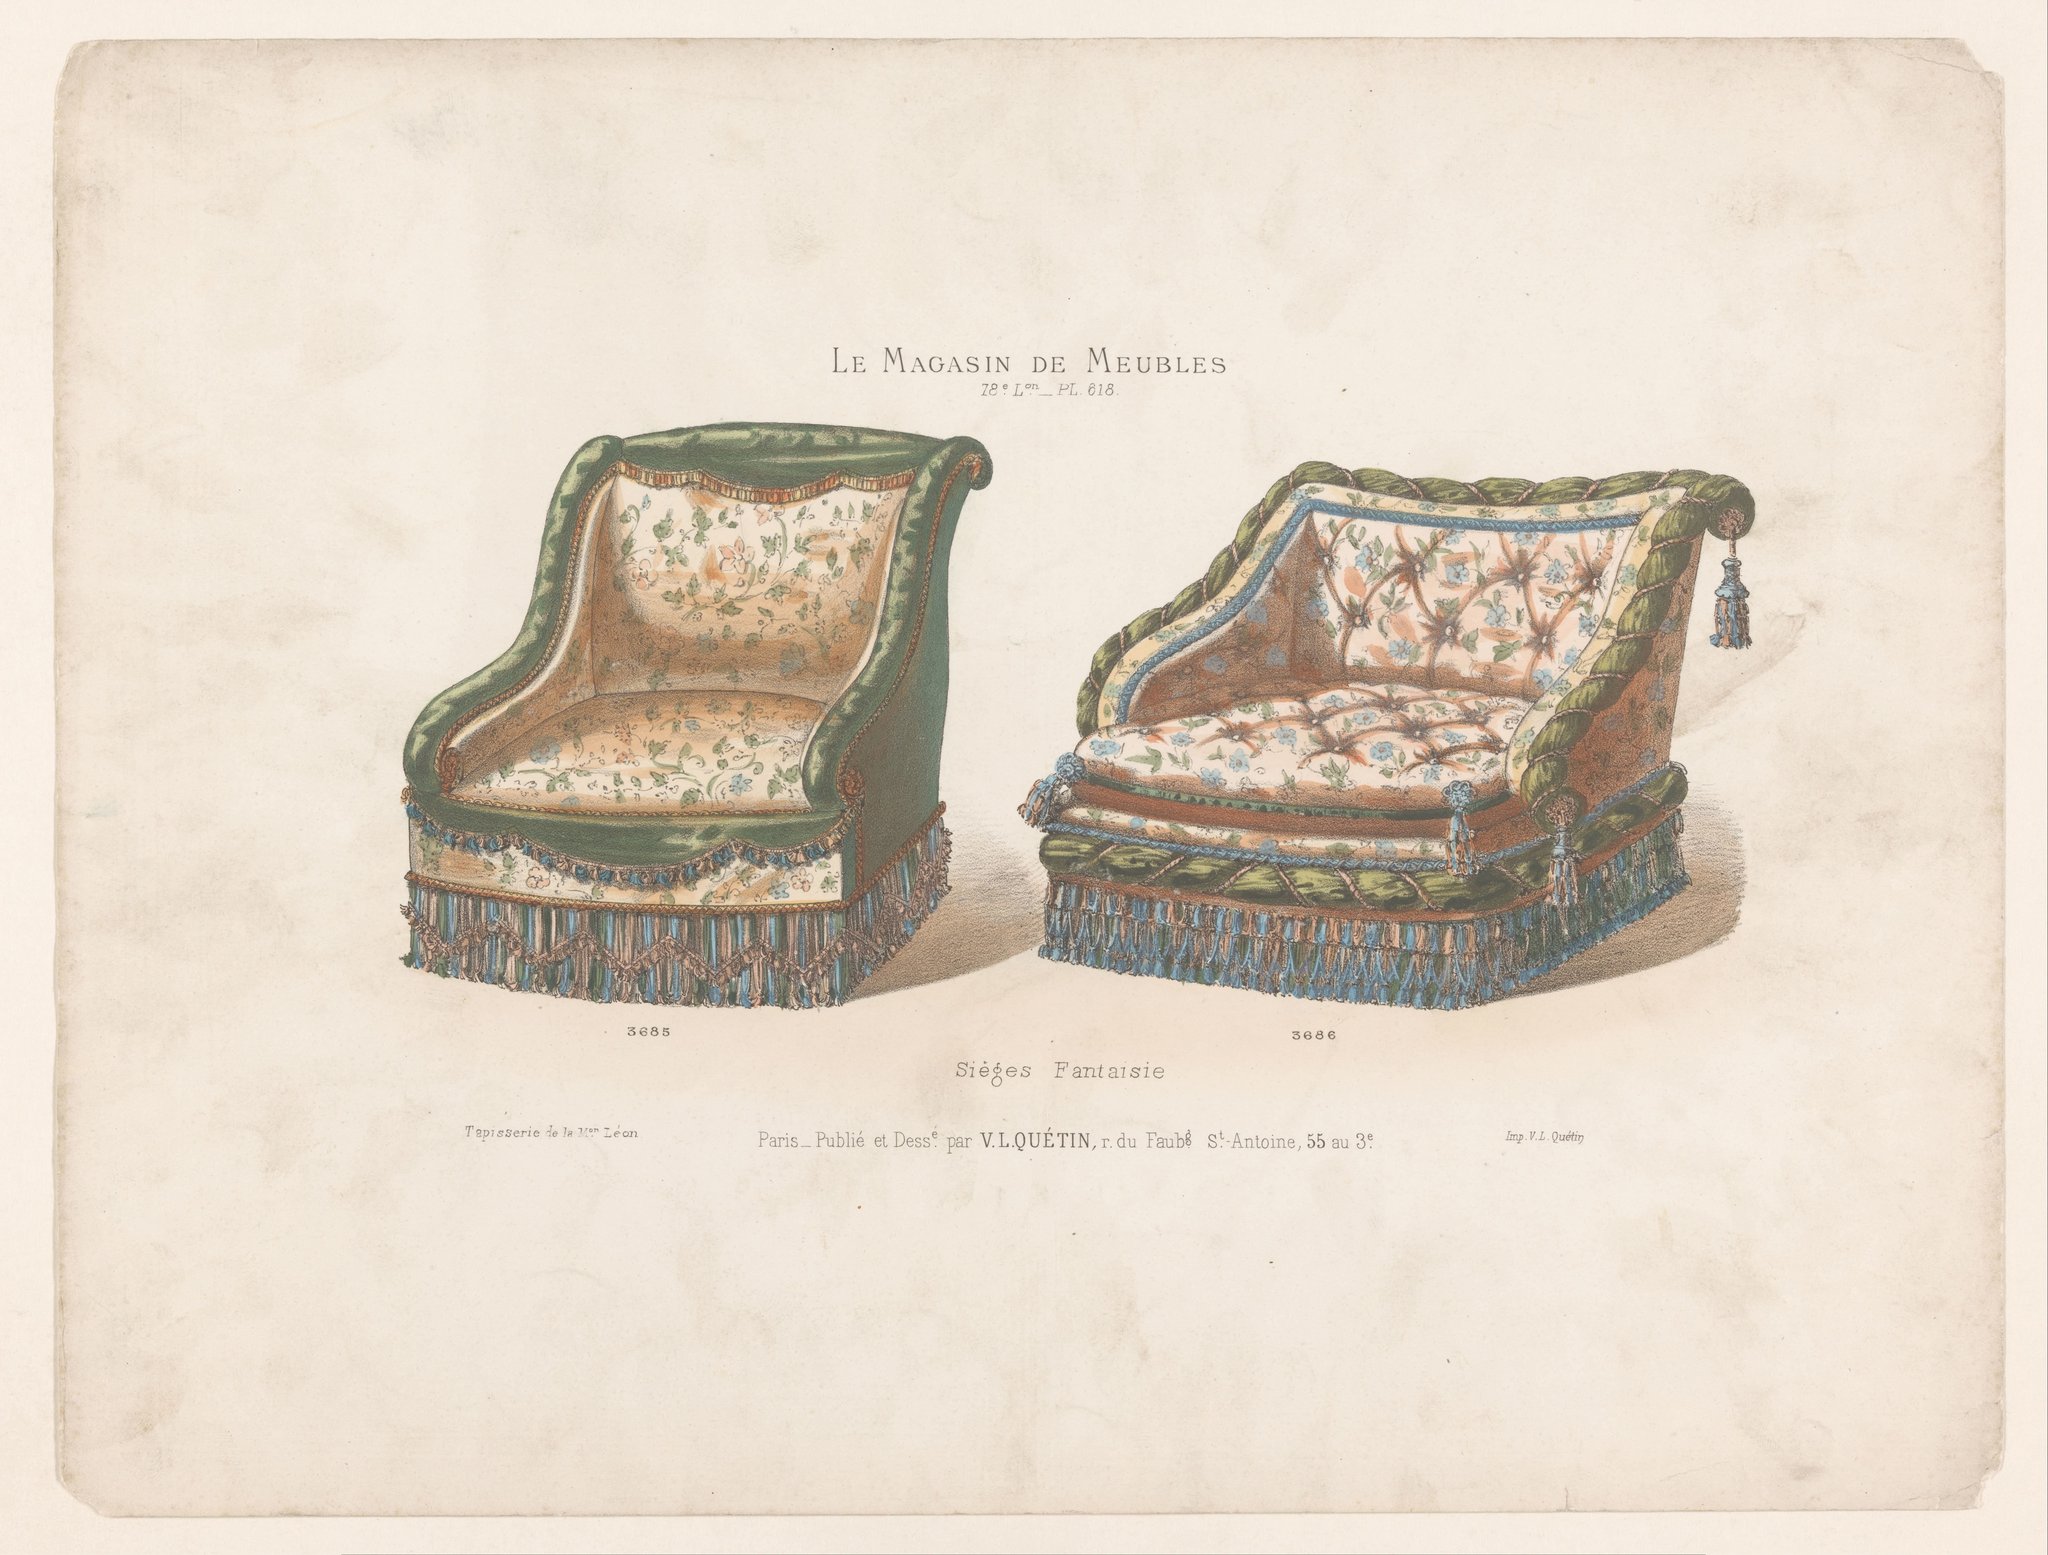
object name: print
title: Sièges Fantaisie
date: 1878-1904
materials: paper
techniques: hand coloring, lithograph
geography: paris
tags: seating furniture